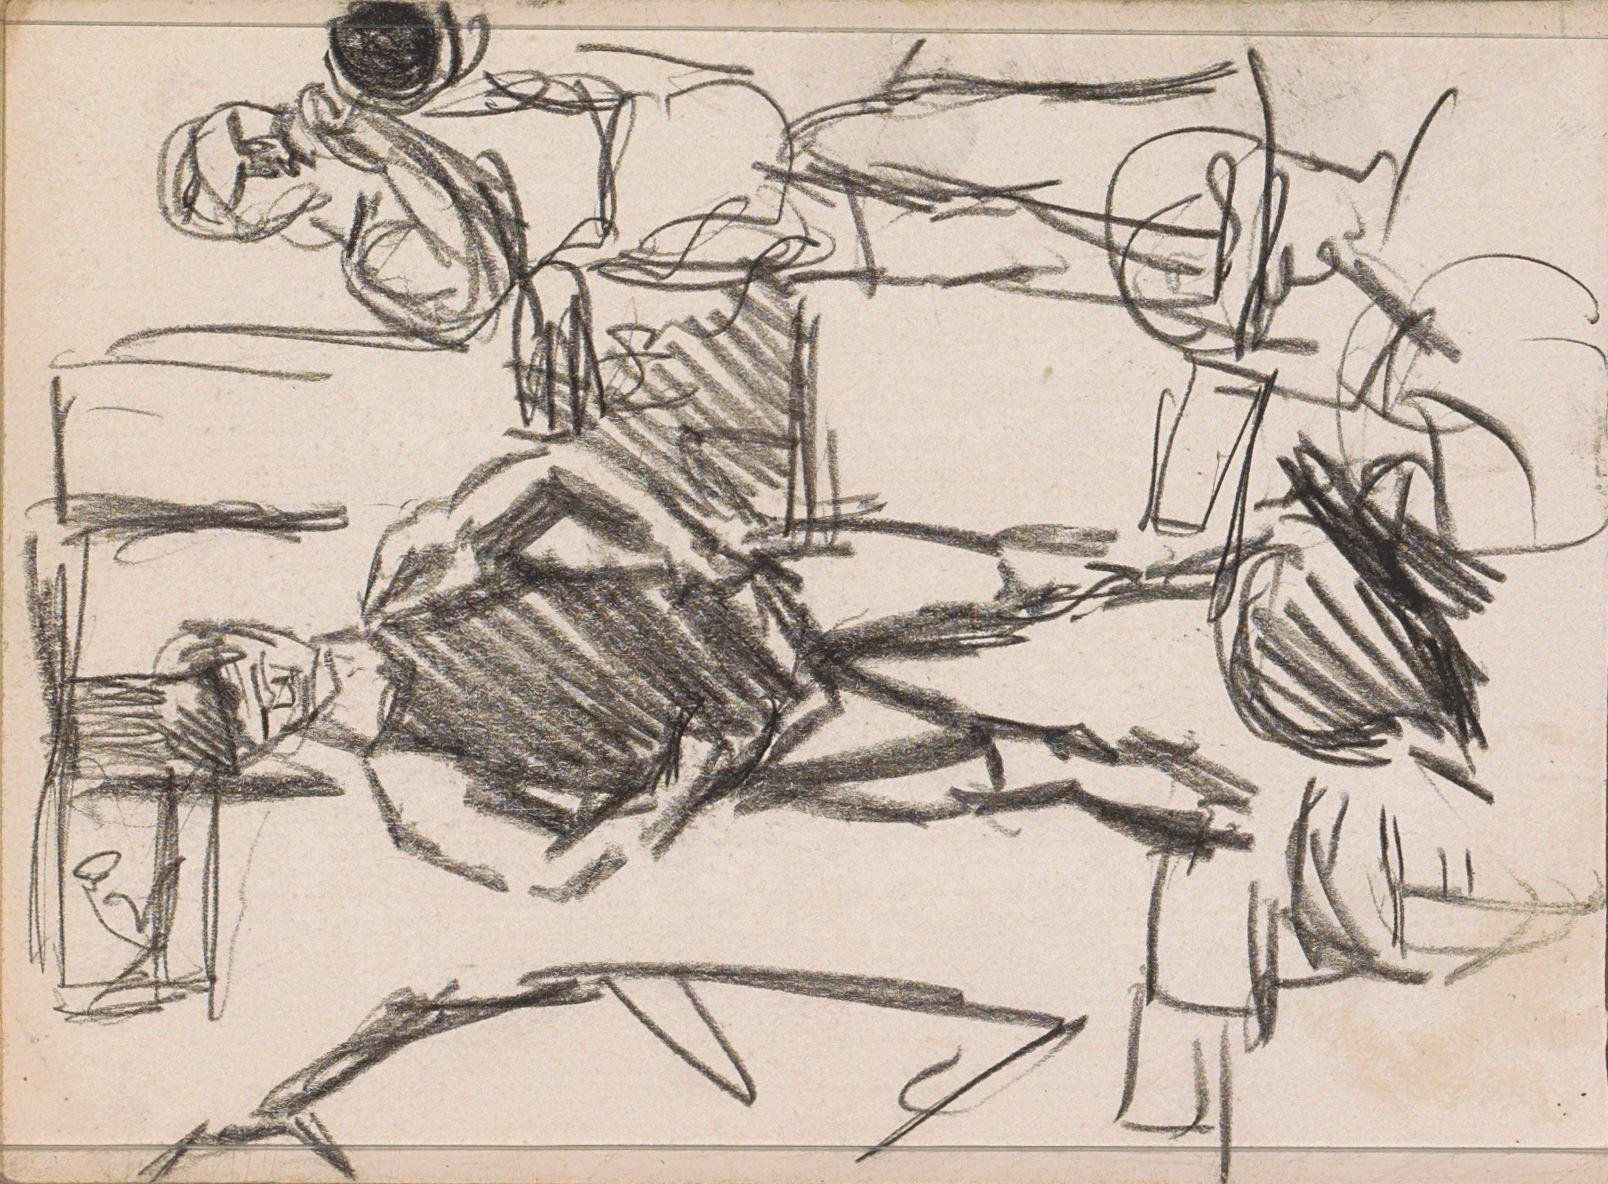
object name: sketchbook leaf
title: Twee variétéartiesten op een podium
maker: isaac israels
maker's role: draughtsman, painter, print maker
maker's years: 1865-1934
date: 1875-1934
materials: chalk, paper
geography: paris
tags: performer, artiste (non-work situations), horn, trumpet, cornet, trombone, tuba (+ artist at work), the audience ~ art performance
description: Rechts mogelijk een trompettist. Vooraan toeschouwers. Pagina 17 uit schetsboek XLV met 85 pagina's.